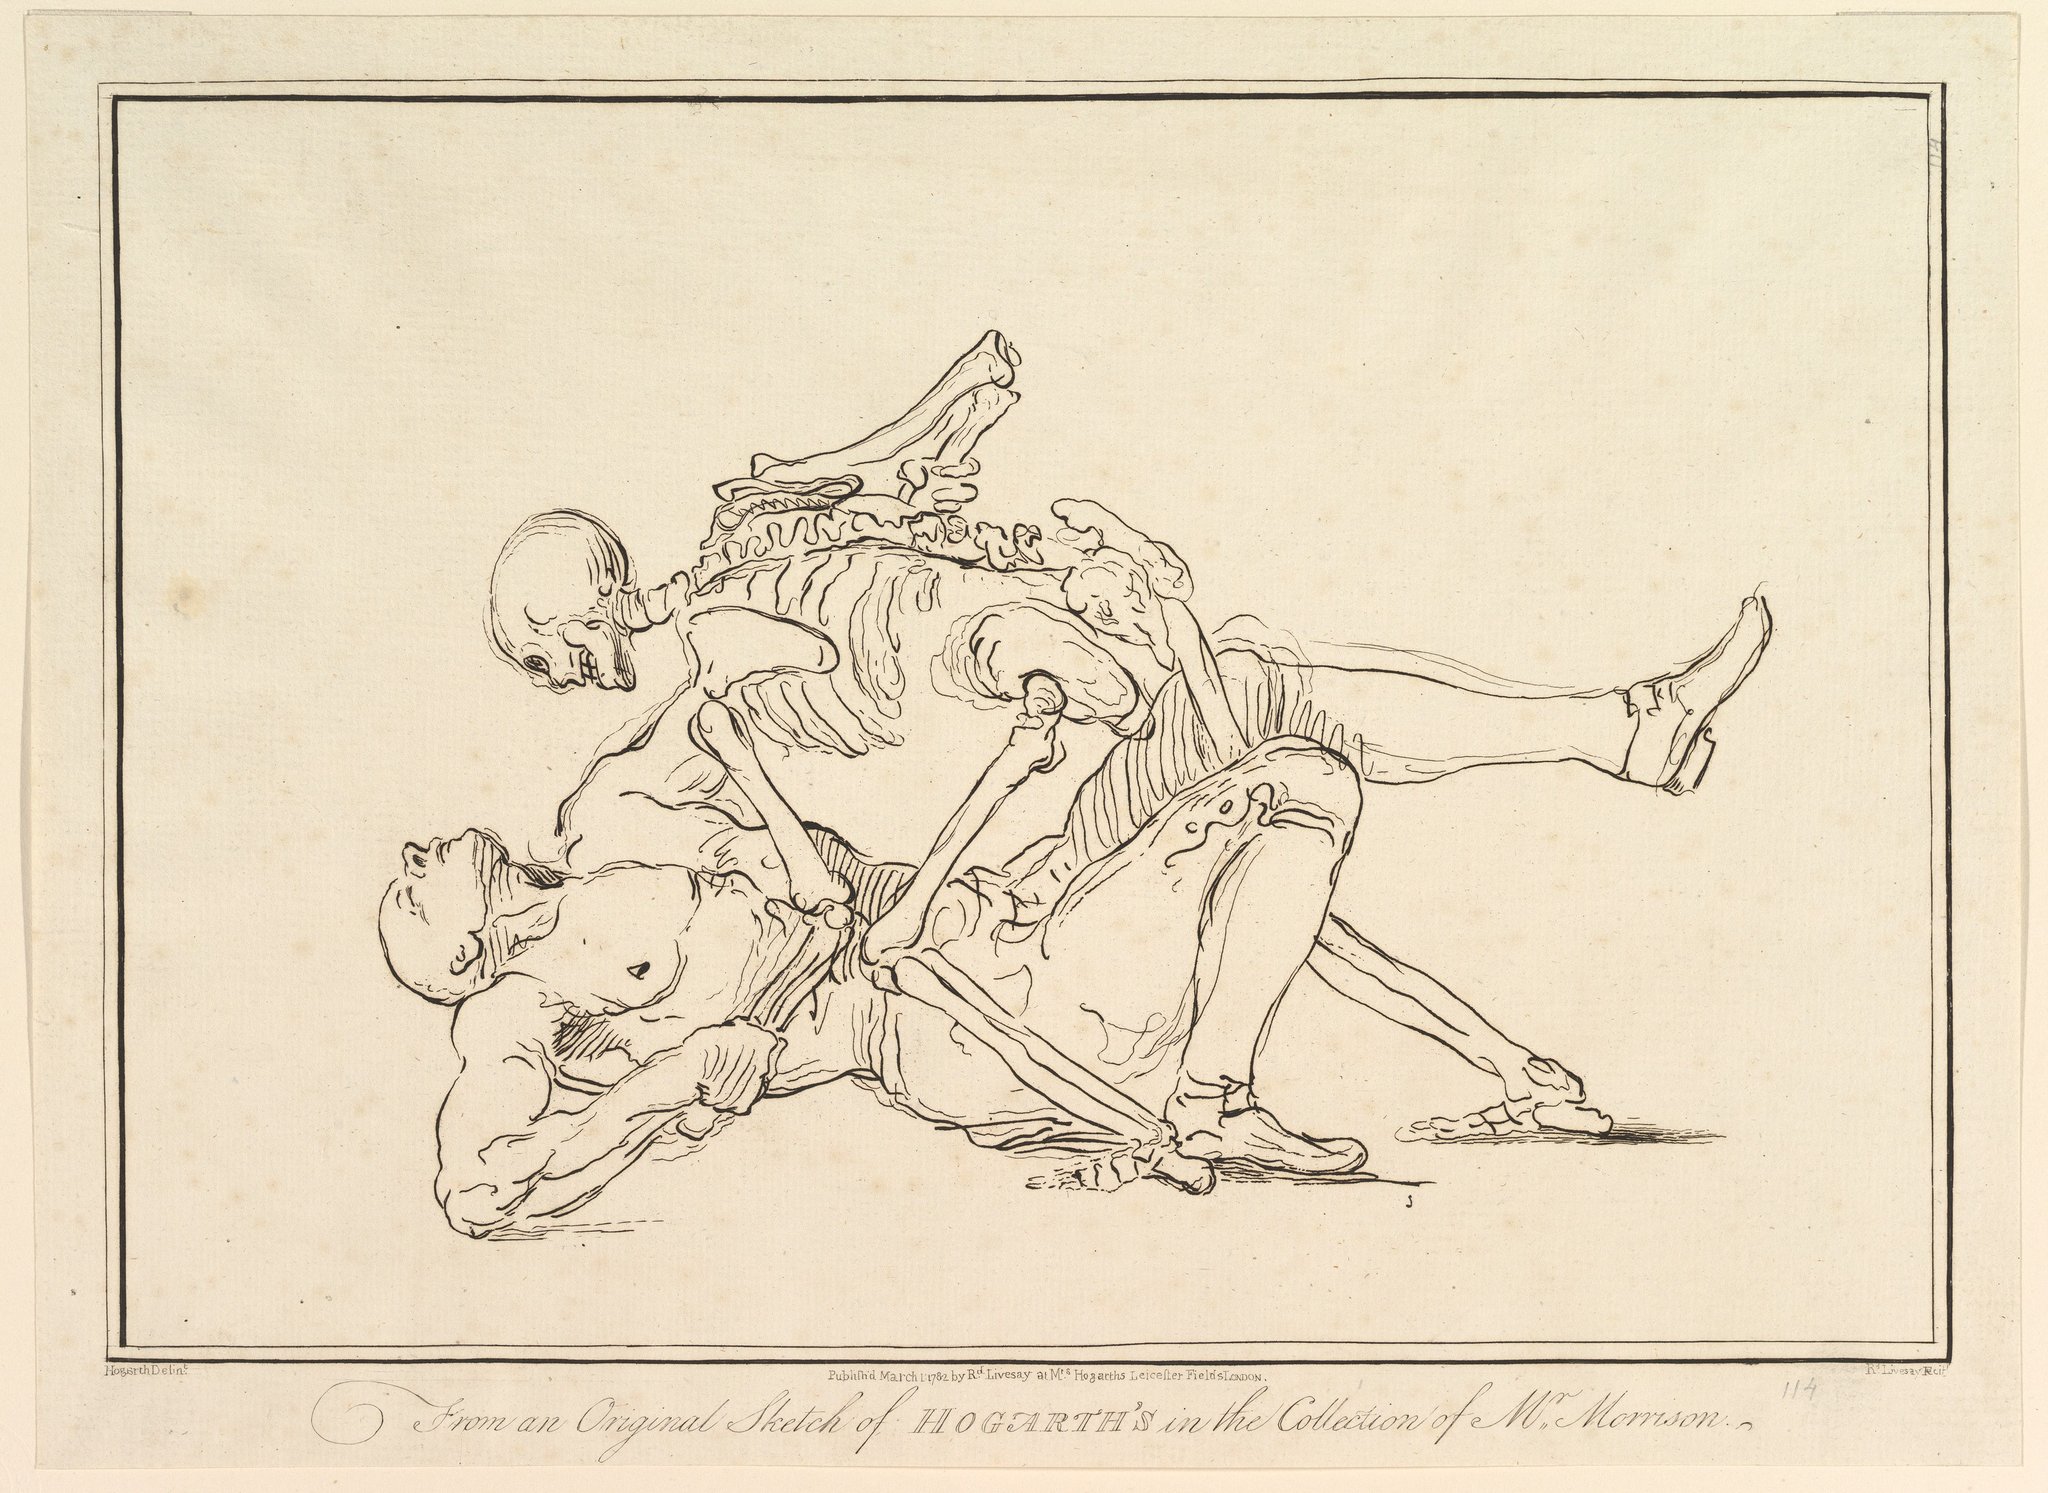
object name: print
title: From an Original Sketch of William Hogarth's in the Collection of Mr. Morrison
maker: richard livesay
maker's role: artist and publisher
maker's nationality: british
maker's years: 1750-1826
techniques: etching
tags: skeletons,men